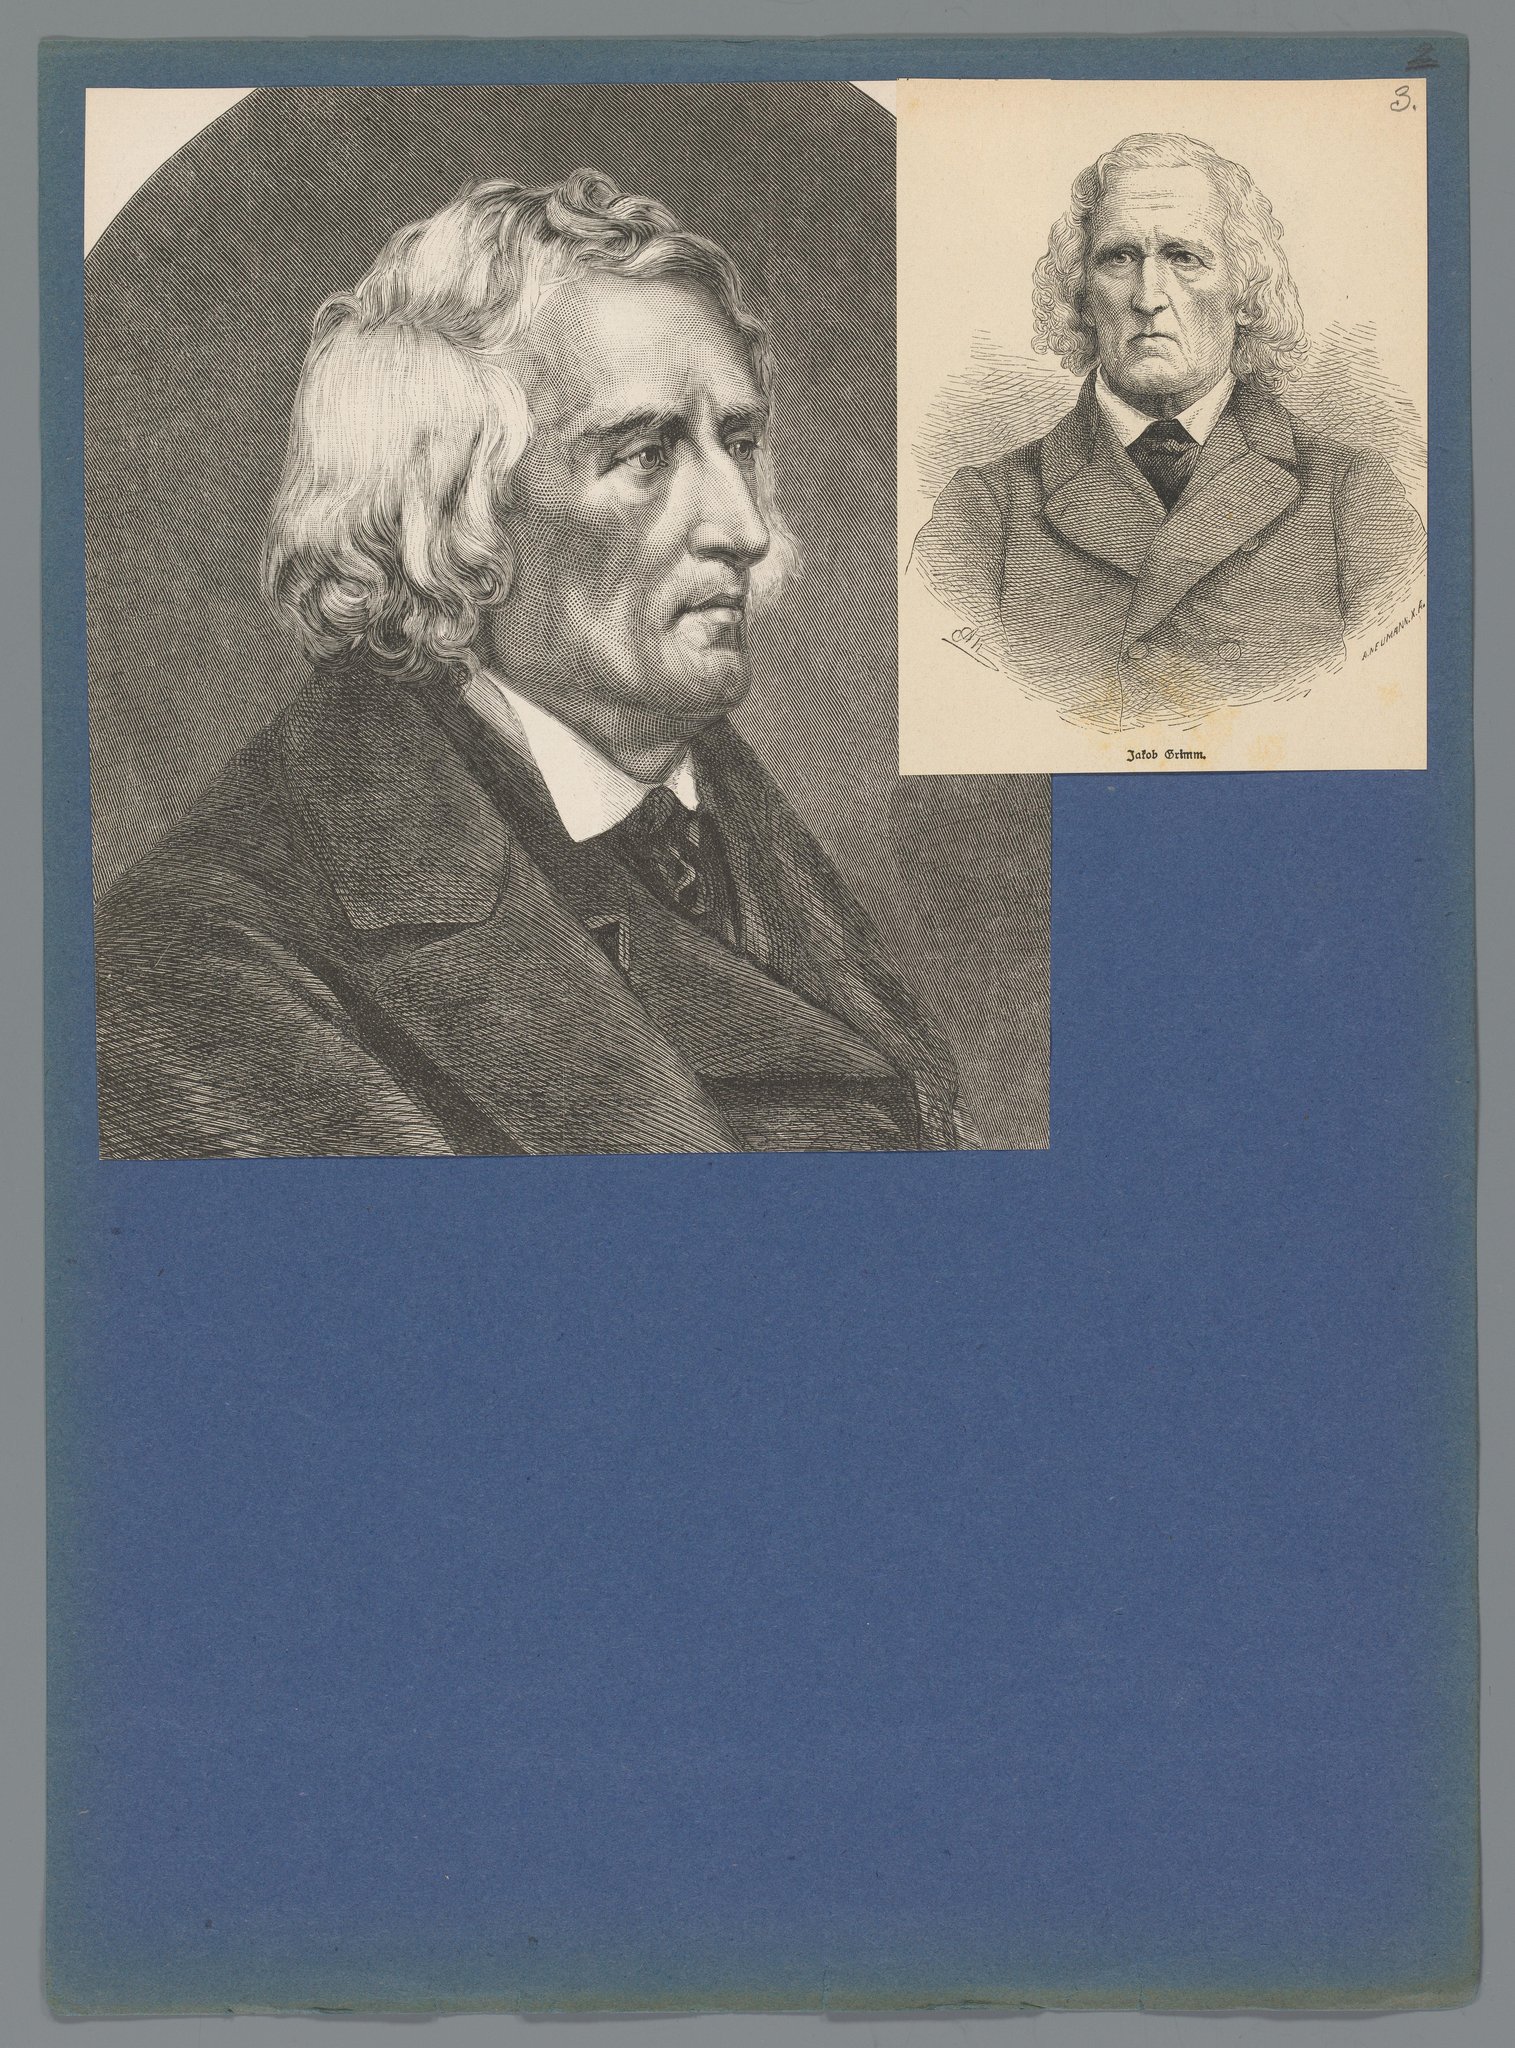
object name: print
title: Blad met twee portretten van Jacob Ludwig Karl Grimm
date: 1850-1900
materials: paper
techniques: letterpress printing, snipping, engraving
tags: berlin, jacob ludwig karl grimm, historical persons, portrait of a writer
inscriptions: number: ‘3’